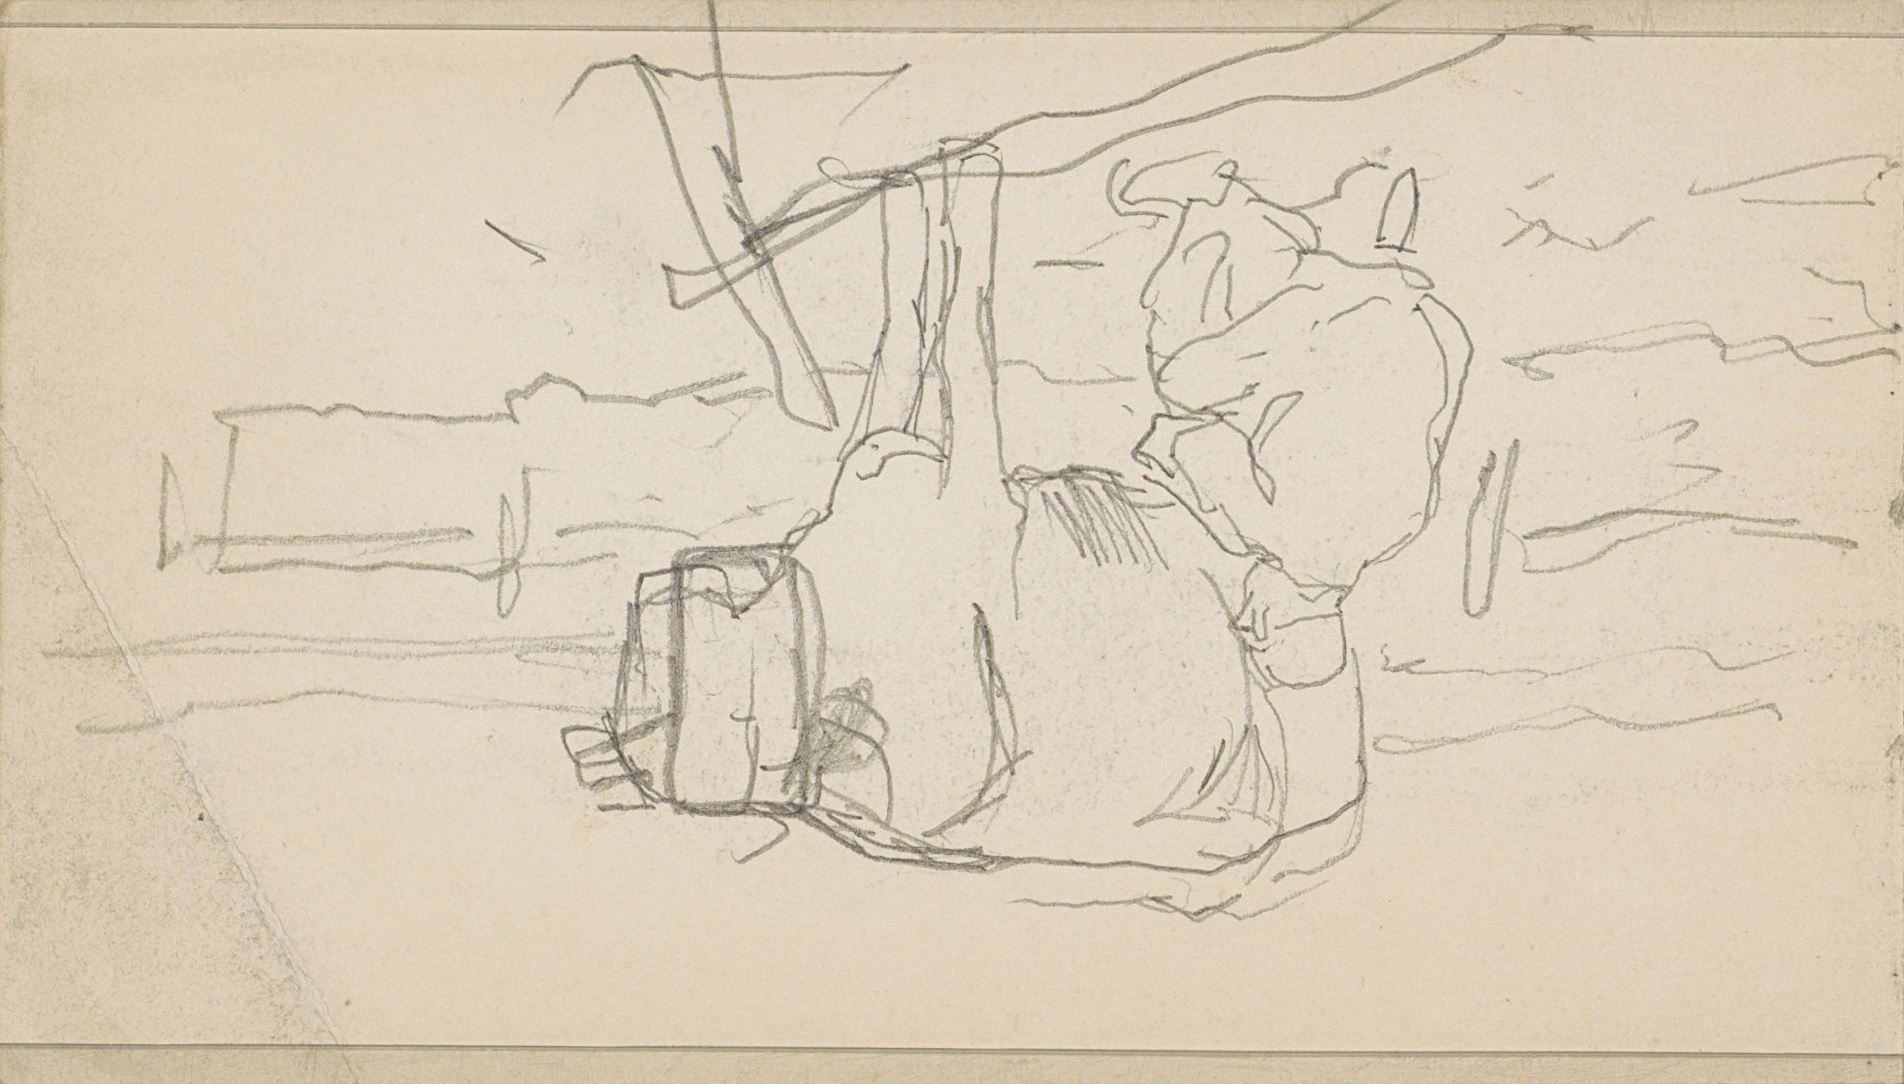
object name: sketchbook leaf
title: Boer die een koe melkt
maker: anton mauve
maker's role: draughtsman, painter, print maker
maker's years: 1838-1888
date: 1876-1879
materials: paper, pencil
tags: farmers, milking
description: De koe staat in een weide omgrensd door een hek. Blad 12 verso uit een schetsboek met 33 bladen.